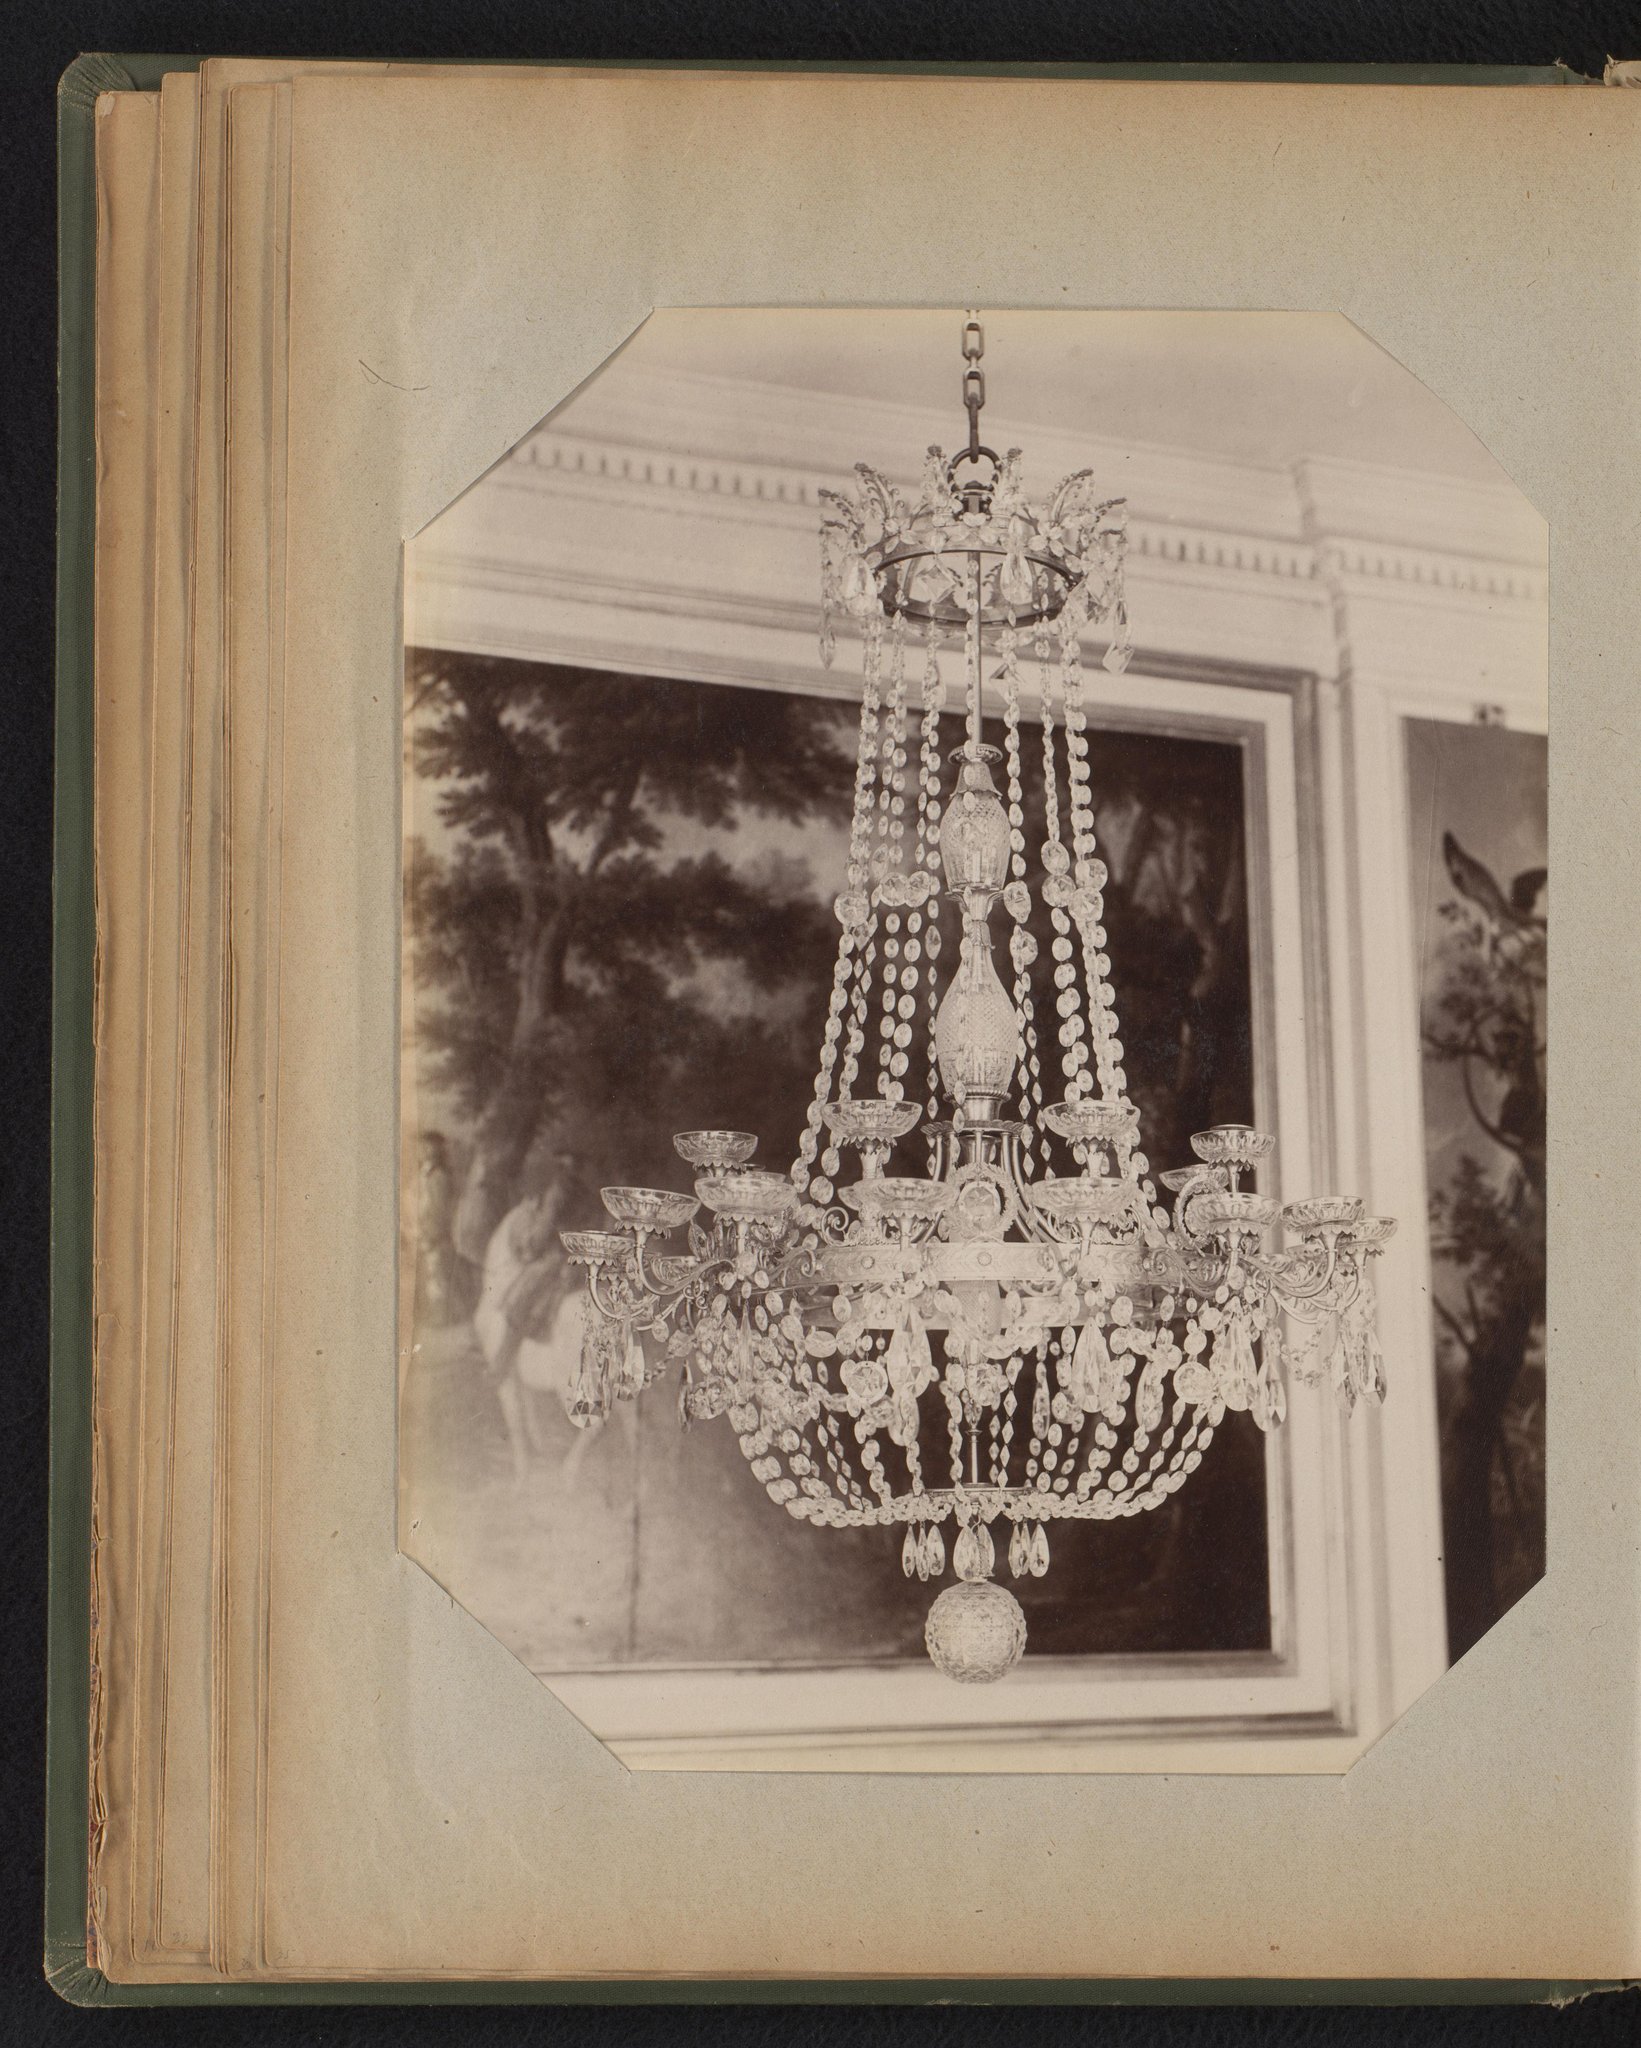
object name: photograph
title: Bronzen en kristallen kroonluchter met kleine decoratie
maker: Anonymous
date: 1860-1900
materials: canvas, cardboard, paper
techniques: albumen print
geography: netherlands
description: Onderdeel van een serie met betrekking tot het interieur van het paleis van Versailles met kroonluchters, deuren, portalen en meubelstukken.